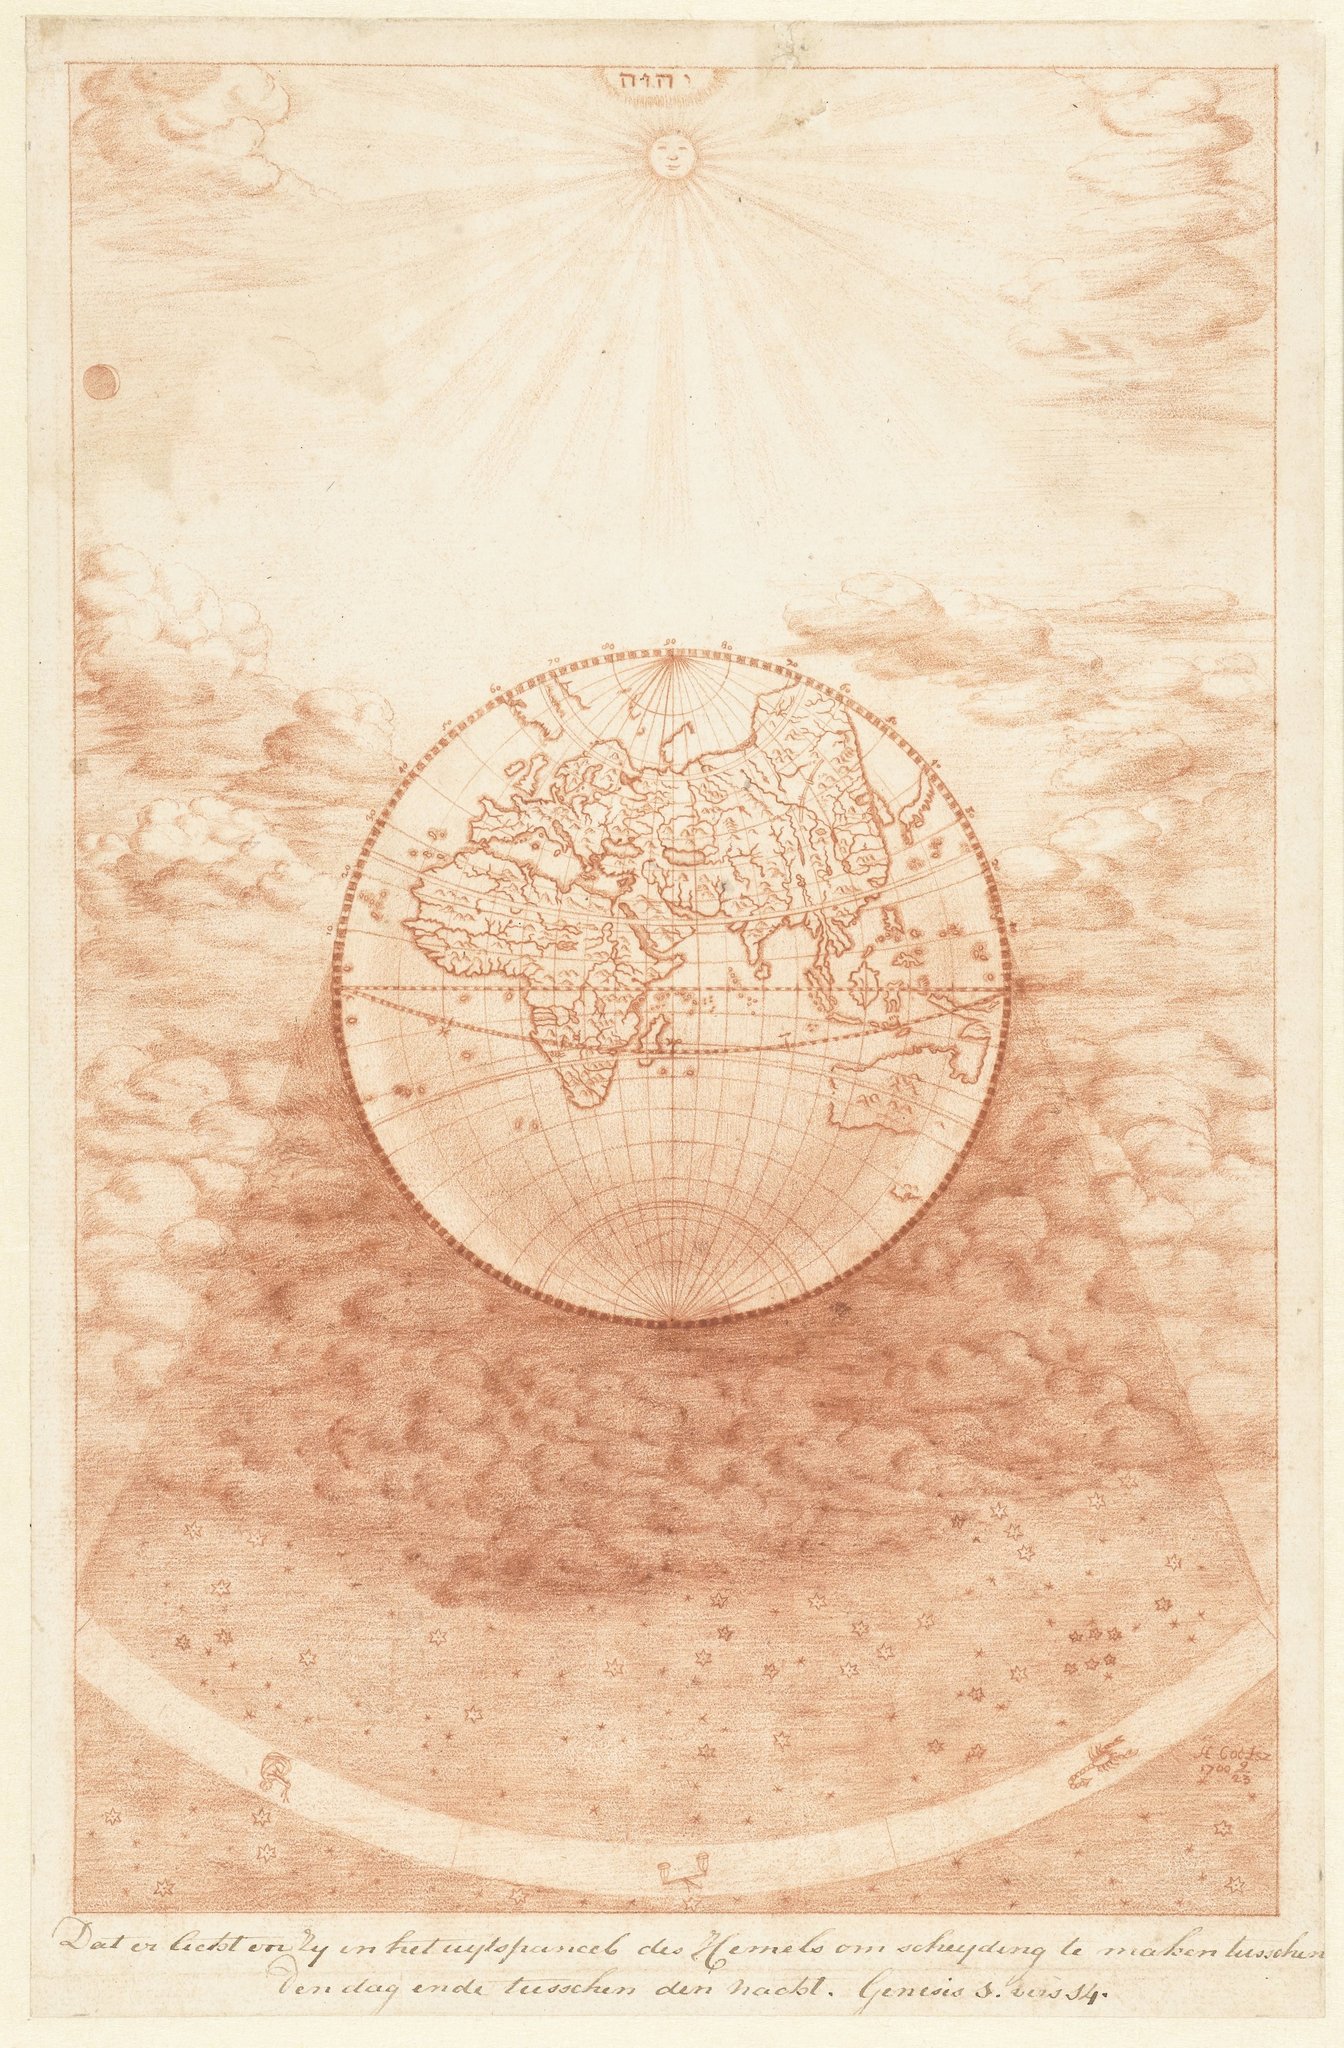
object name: drawing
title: De Schepping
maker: herman coets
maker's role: draughtsman, print maker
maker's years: 1663-1711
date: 1700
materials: chalk, paper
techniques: pouncing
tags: division of light and darkness, night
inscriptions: date: ‘1700 9/23’